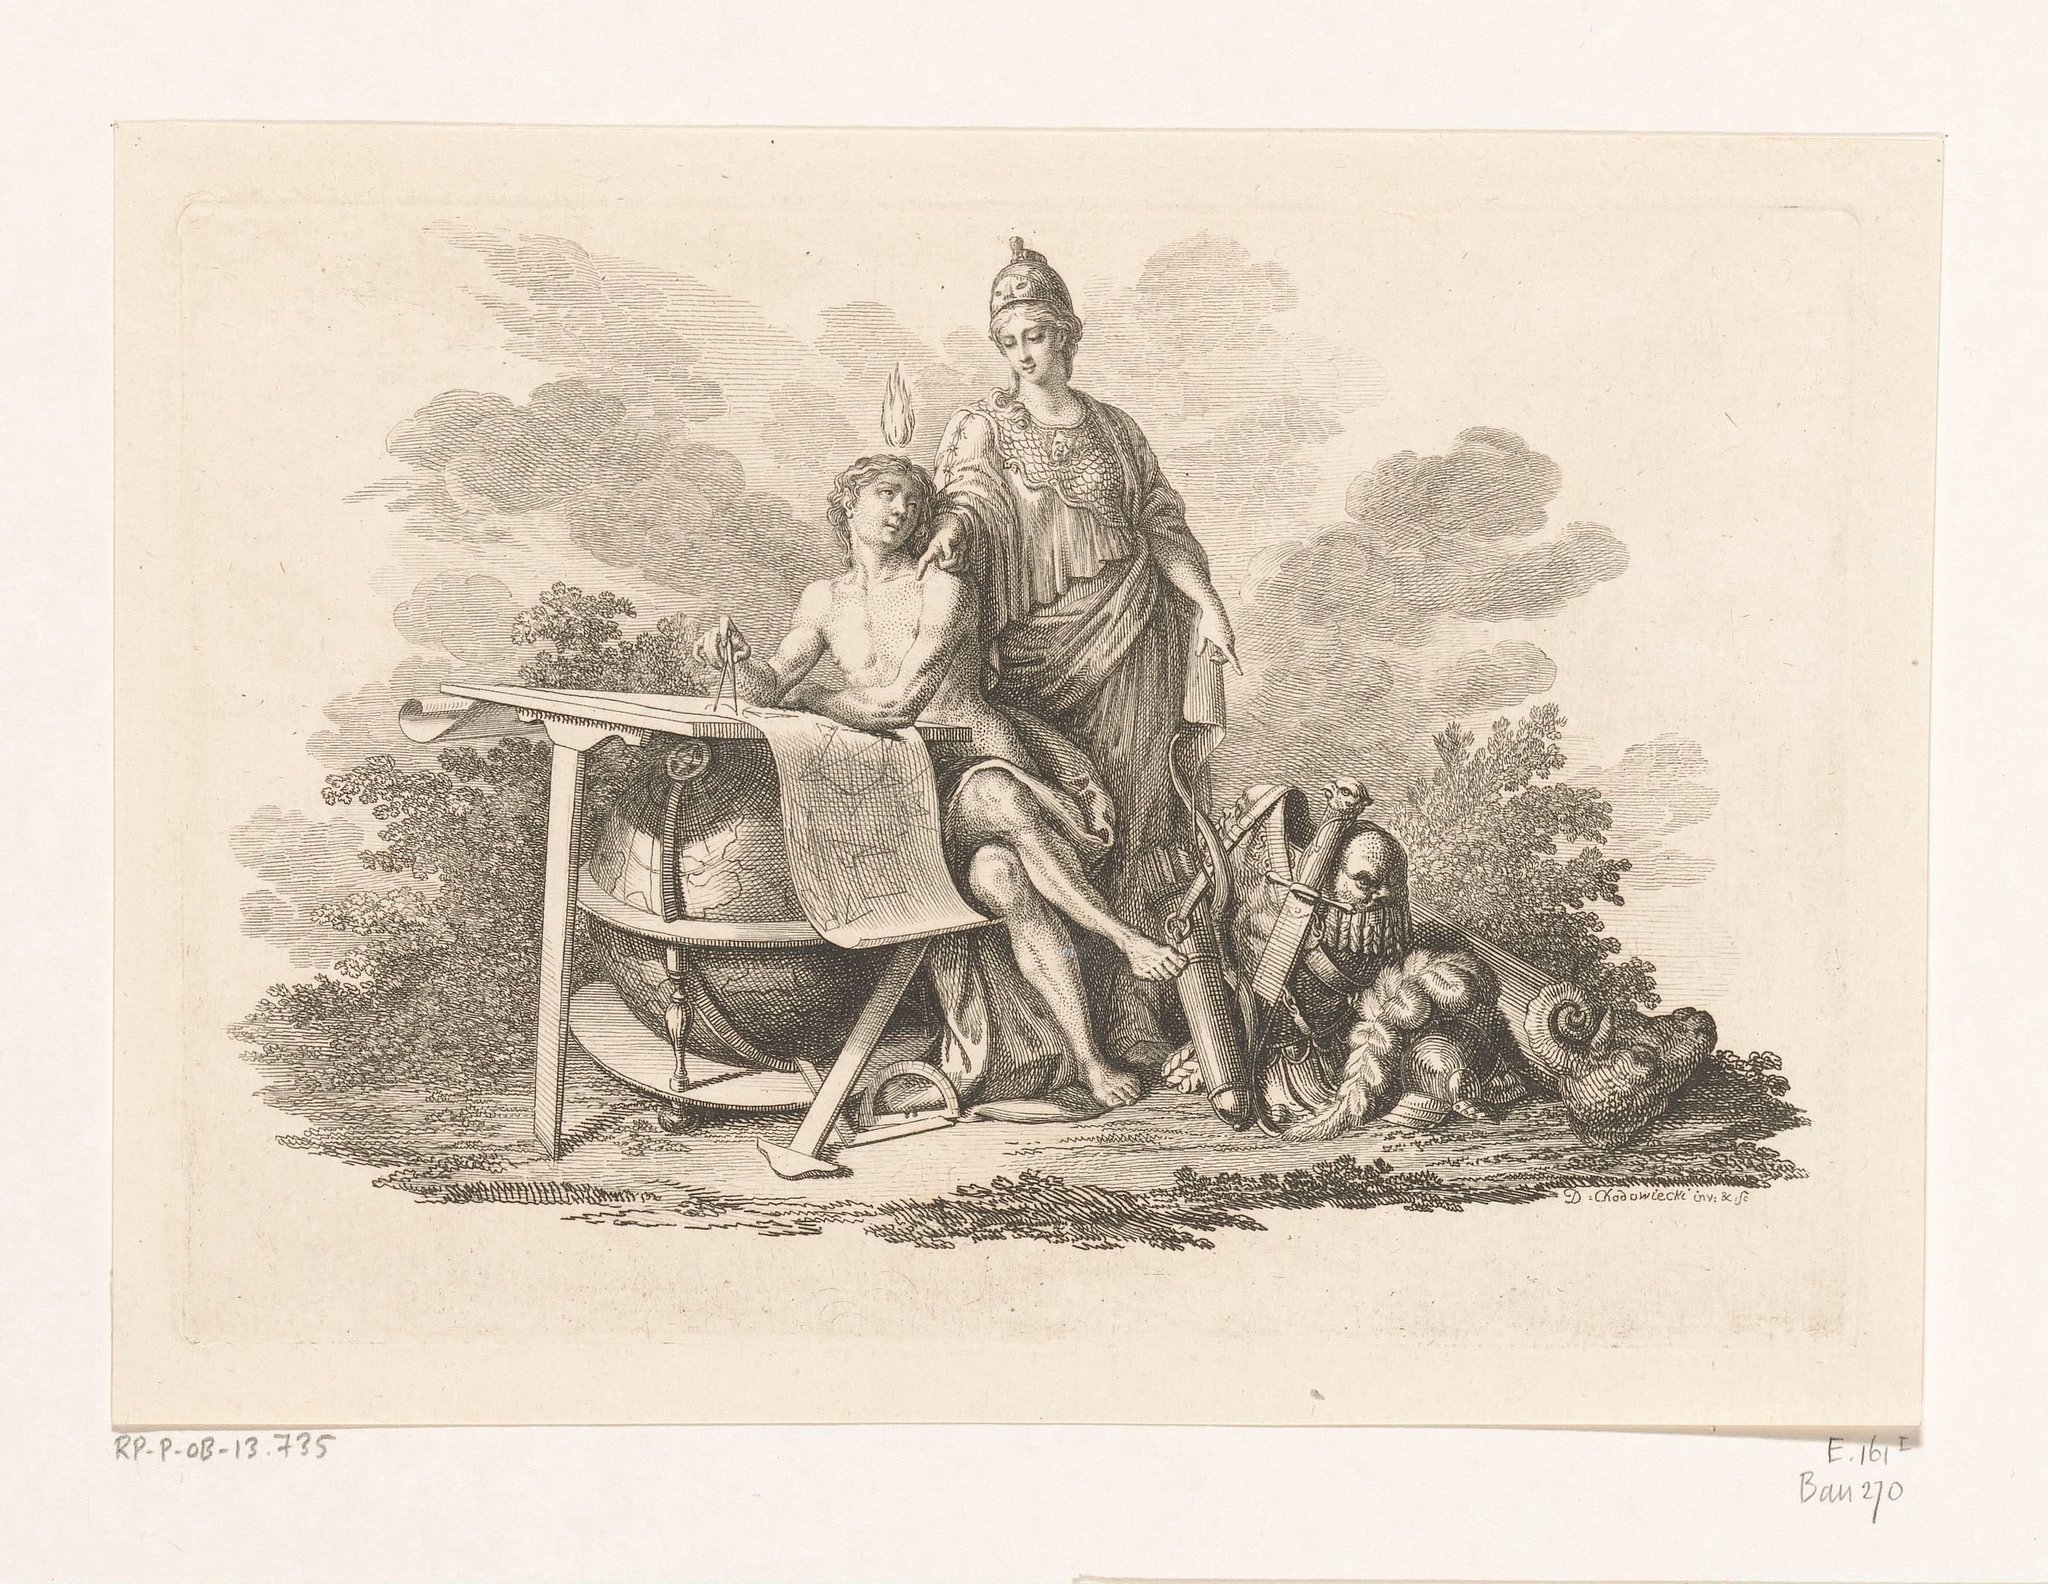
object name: print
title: Minerva onderricht het militair genie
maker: daniel nikolaus chodowiecki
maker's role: draughtsman, print maker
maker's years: 1726-1801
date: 1776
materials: paper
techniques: etching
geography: berlin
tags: design, plan (~ production), drawing-instruments, (story of) minerva (pallas, athena), globe, (military) equipment and supply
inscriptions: collector's mark: Lugt 2228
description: De tweede staat van deze prent is gebruikt in: Tielcke, Johann Gottlieb. Mémoires pour servir à l'art et l'histoire de la guerre de 1756. jusqu'à 1763. Freiberg, Barthel, 1777.